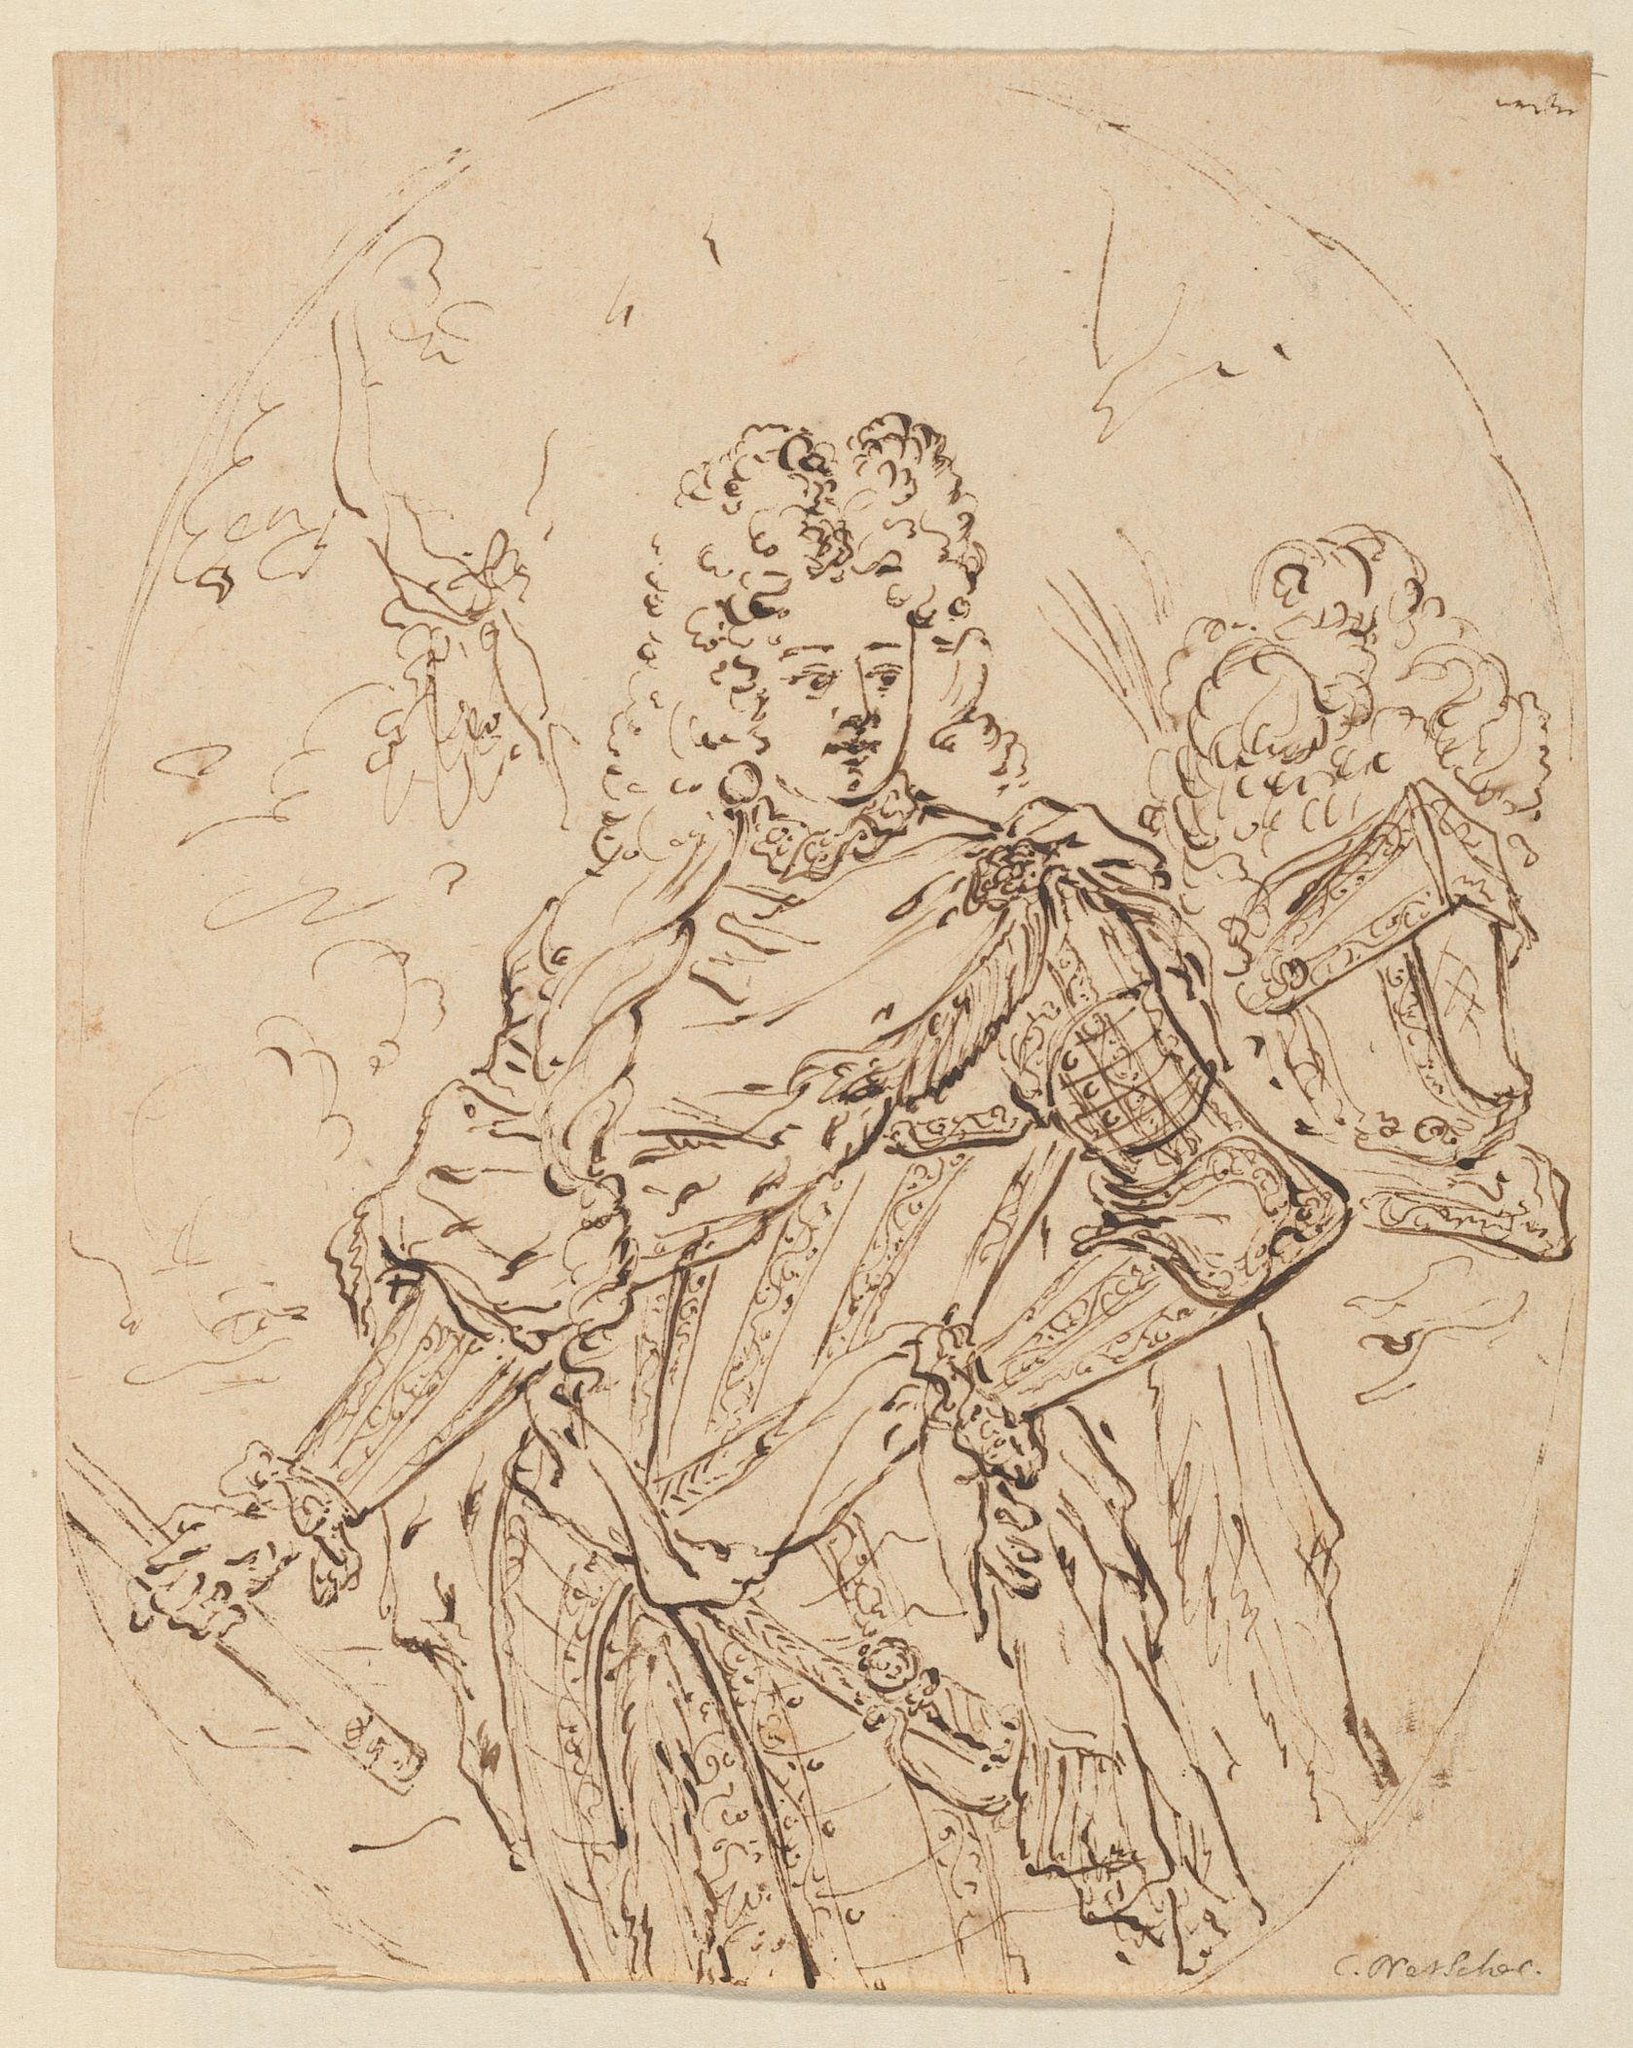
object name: drawing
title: Portret van een geharnaste man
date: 1649-1723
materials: ink, paper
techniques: pen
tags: helmet, armour, baton of general, historical persons not known by name